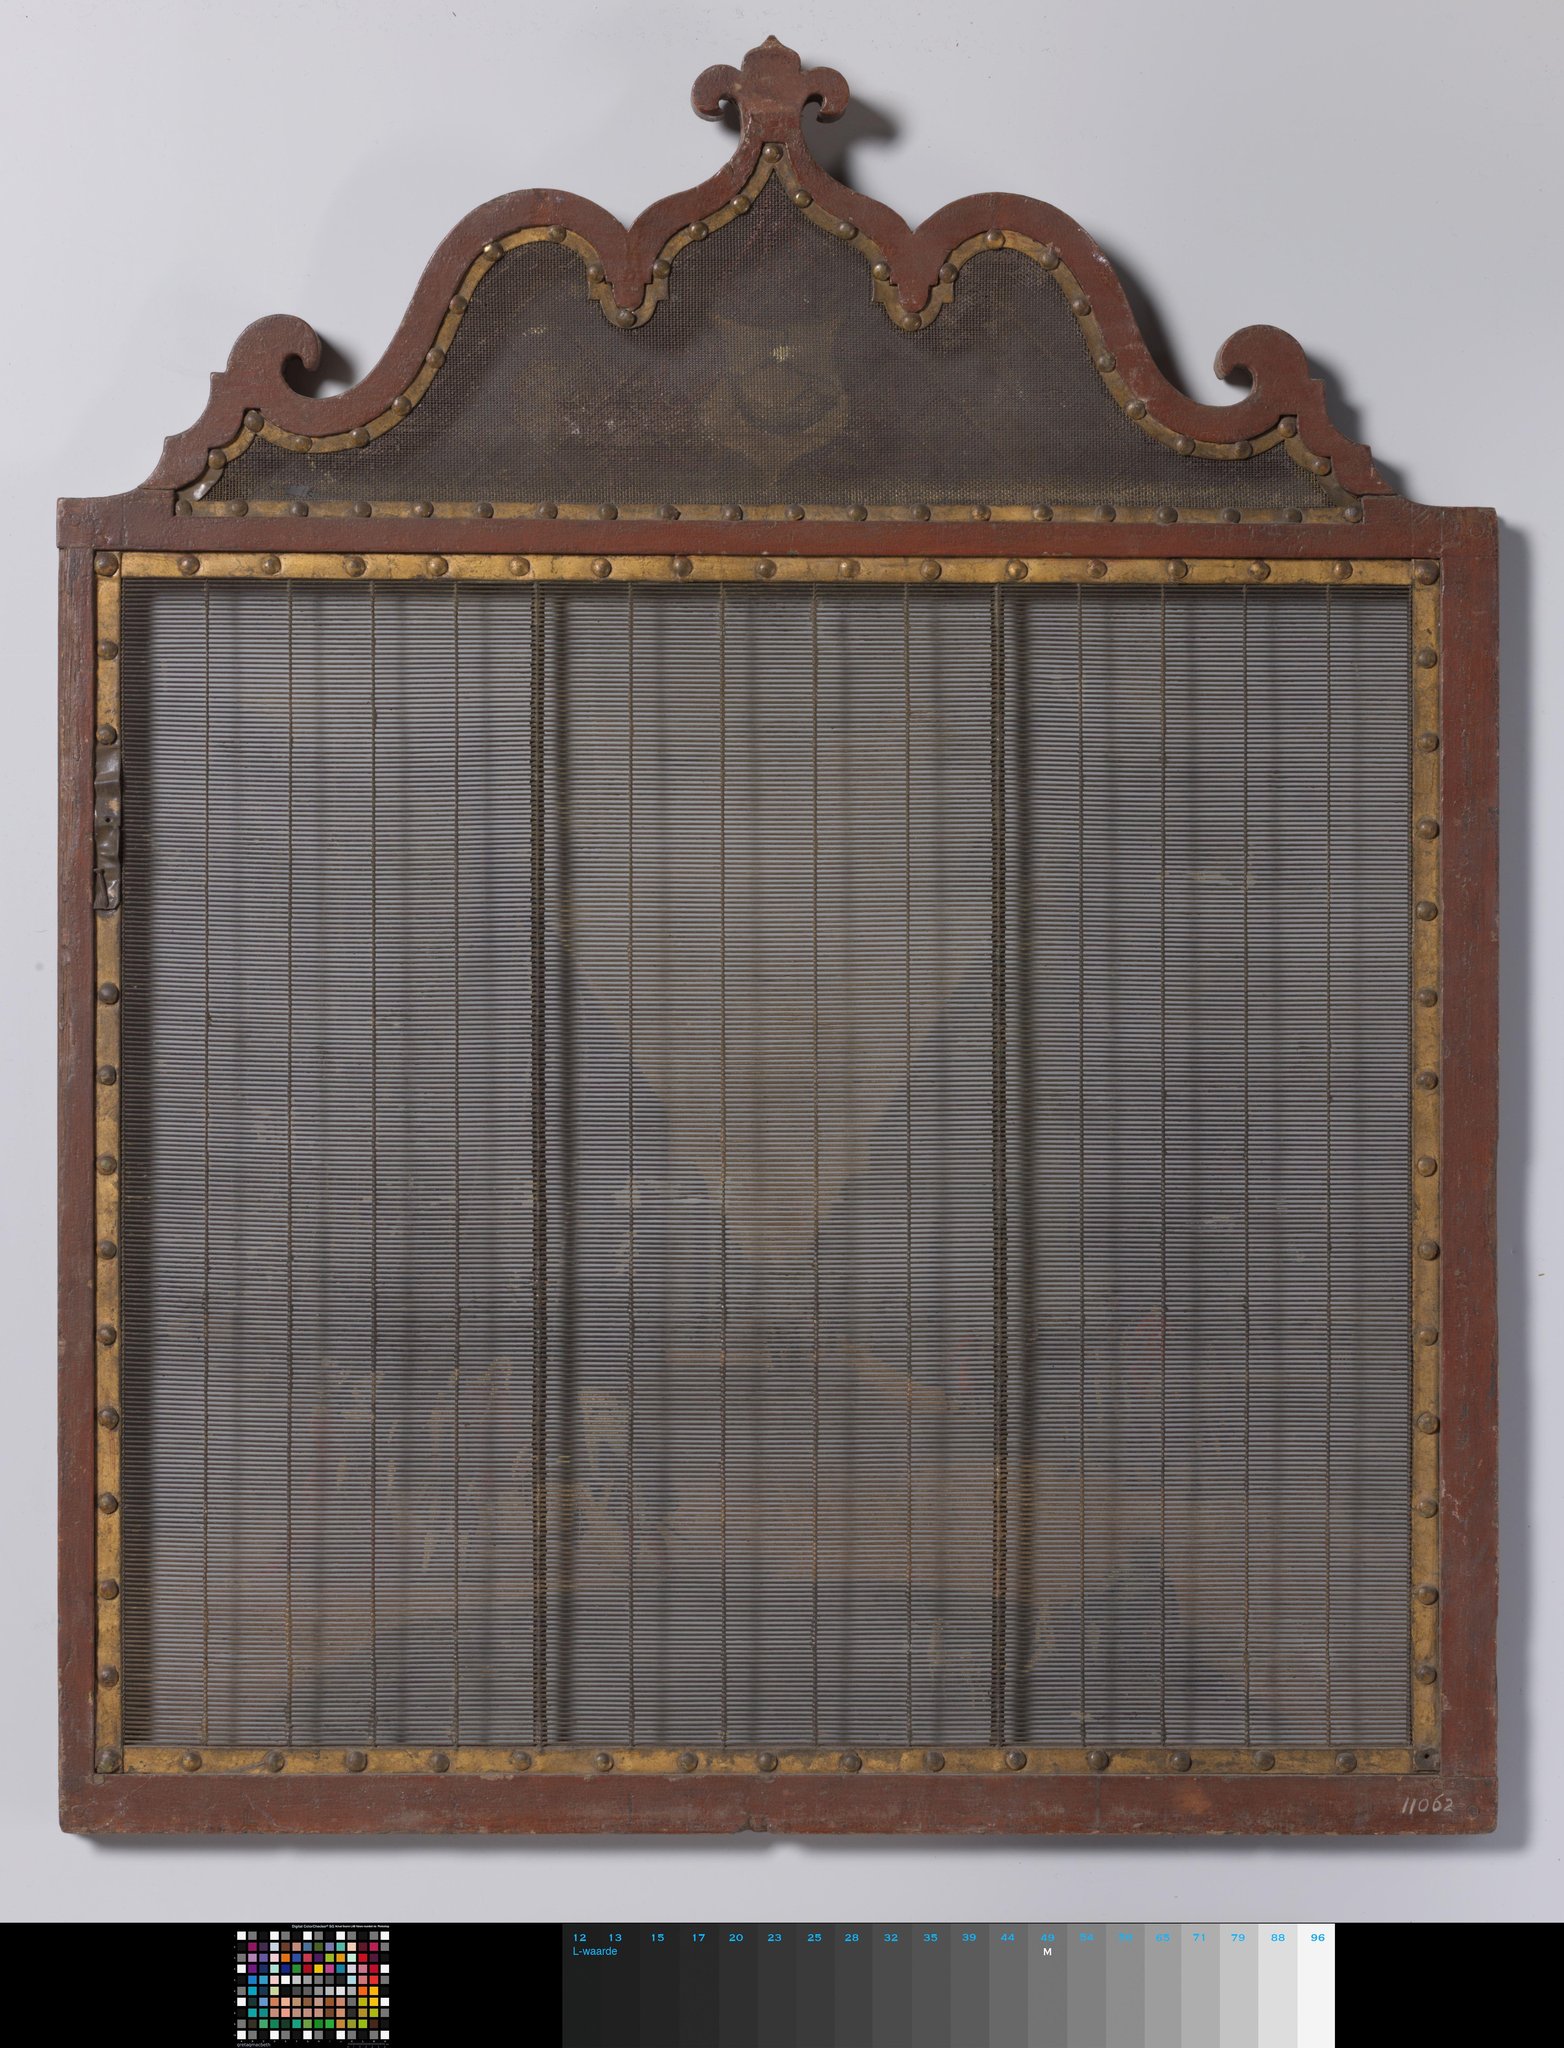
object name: hor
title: Raamhor beschilderd met een gezicht in een lusthof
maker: Anonymous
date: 1700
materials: silver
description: Raamhor beschilderd met een gezicht in een lusthof. Op de voorgrond een deftig gezelschap, enige ruiters, enz. In de bekroning een wapenschild met een zwarte hoorn op zilveren veld.